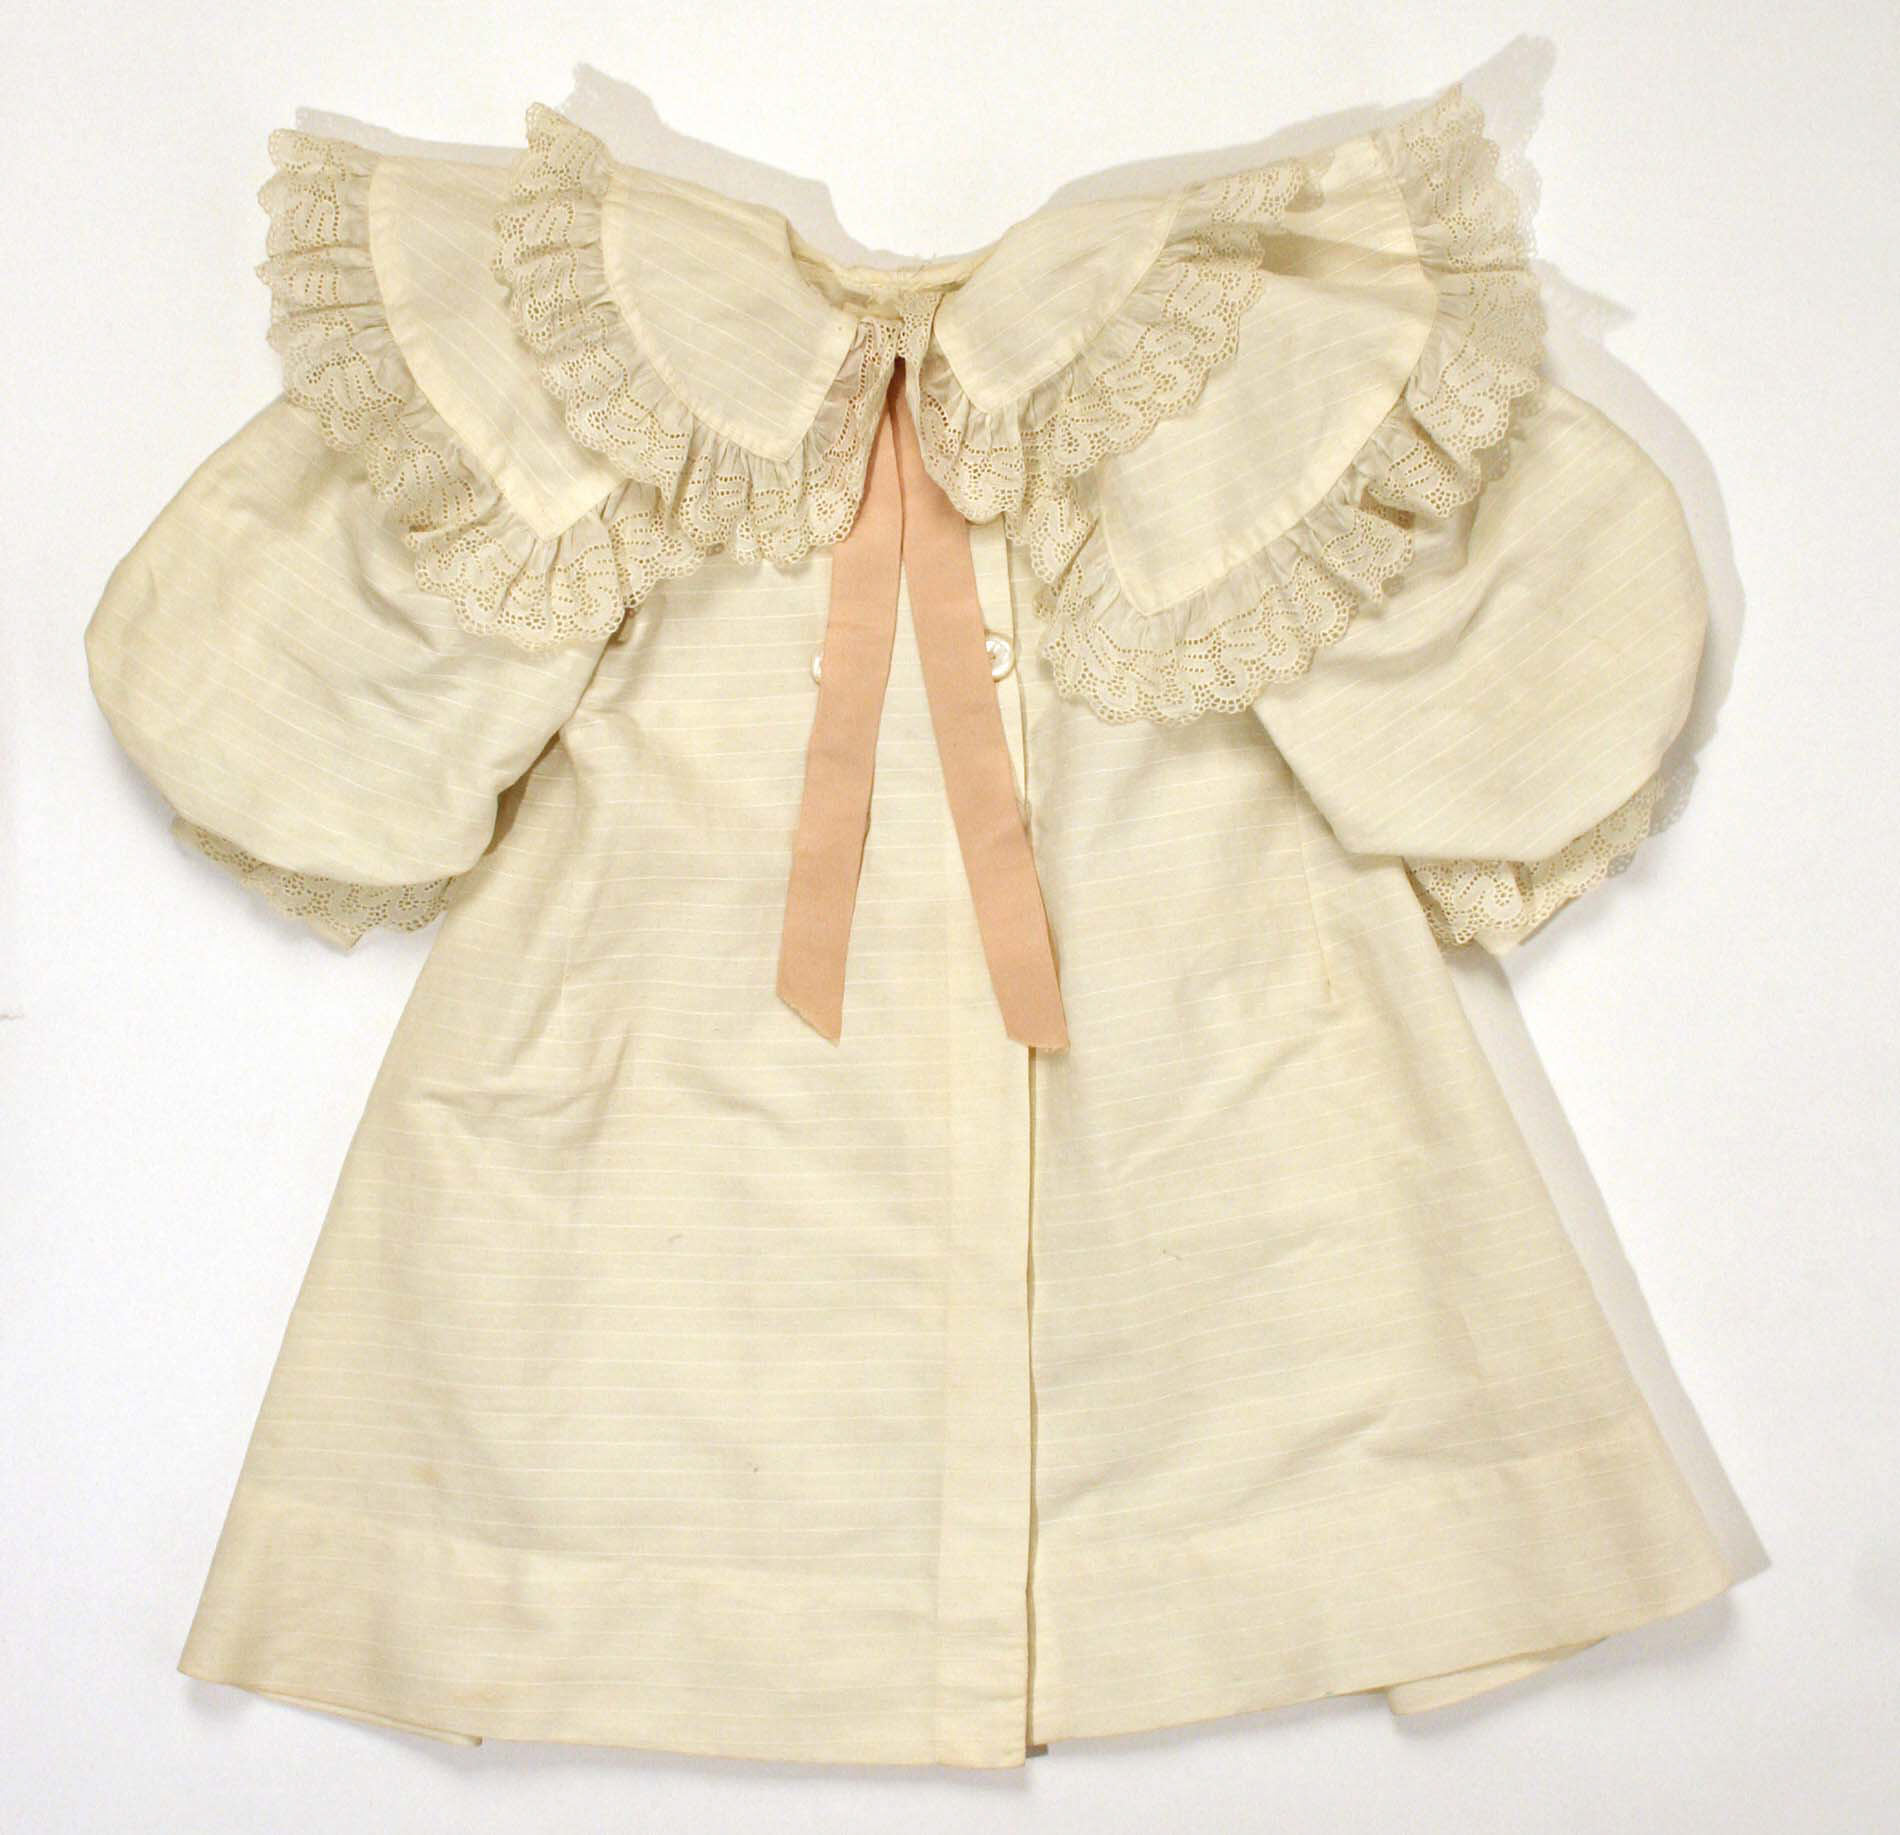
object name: ensemble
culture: american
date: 1890-1899